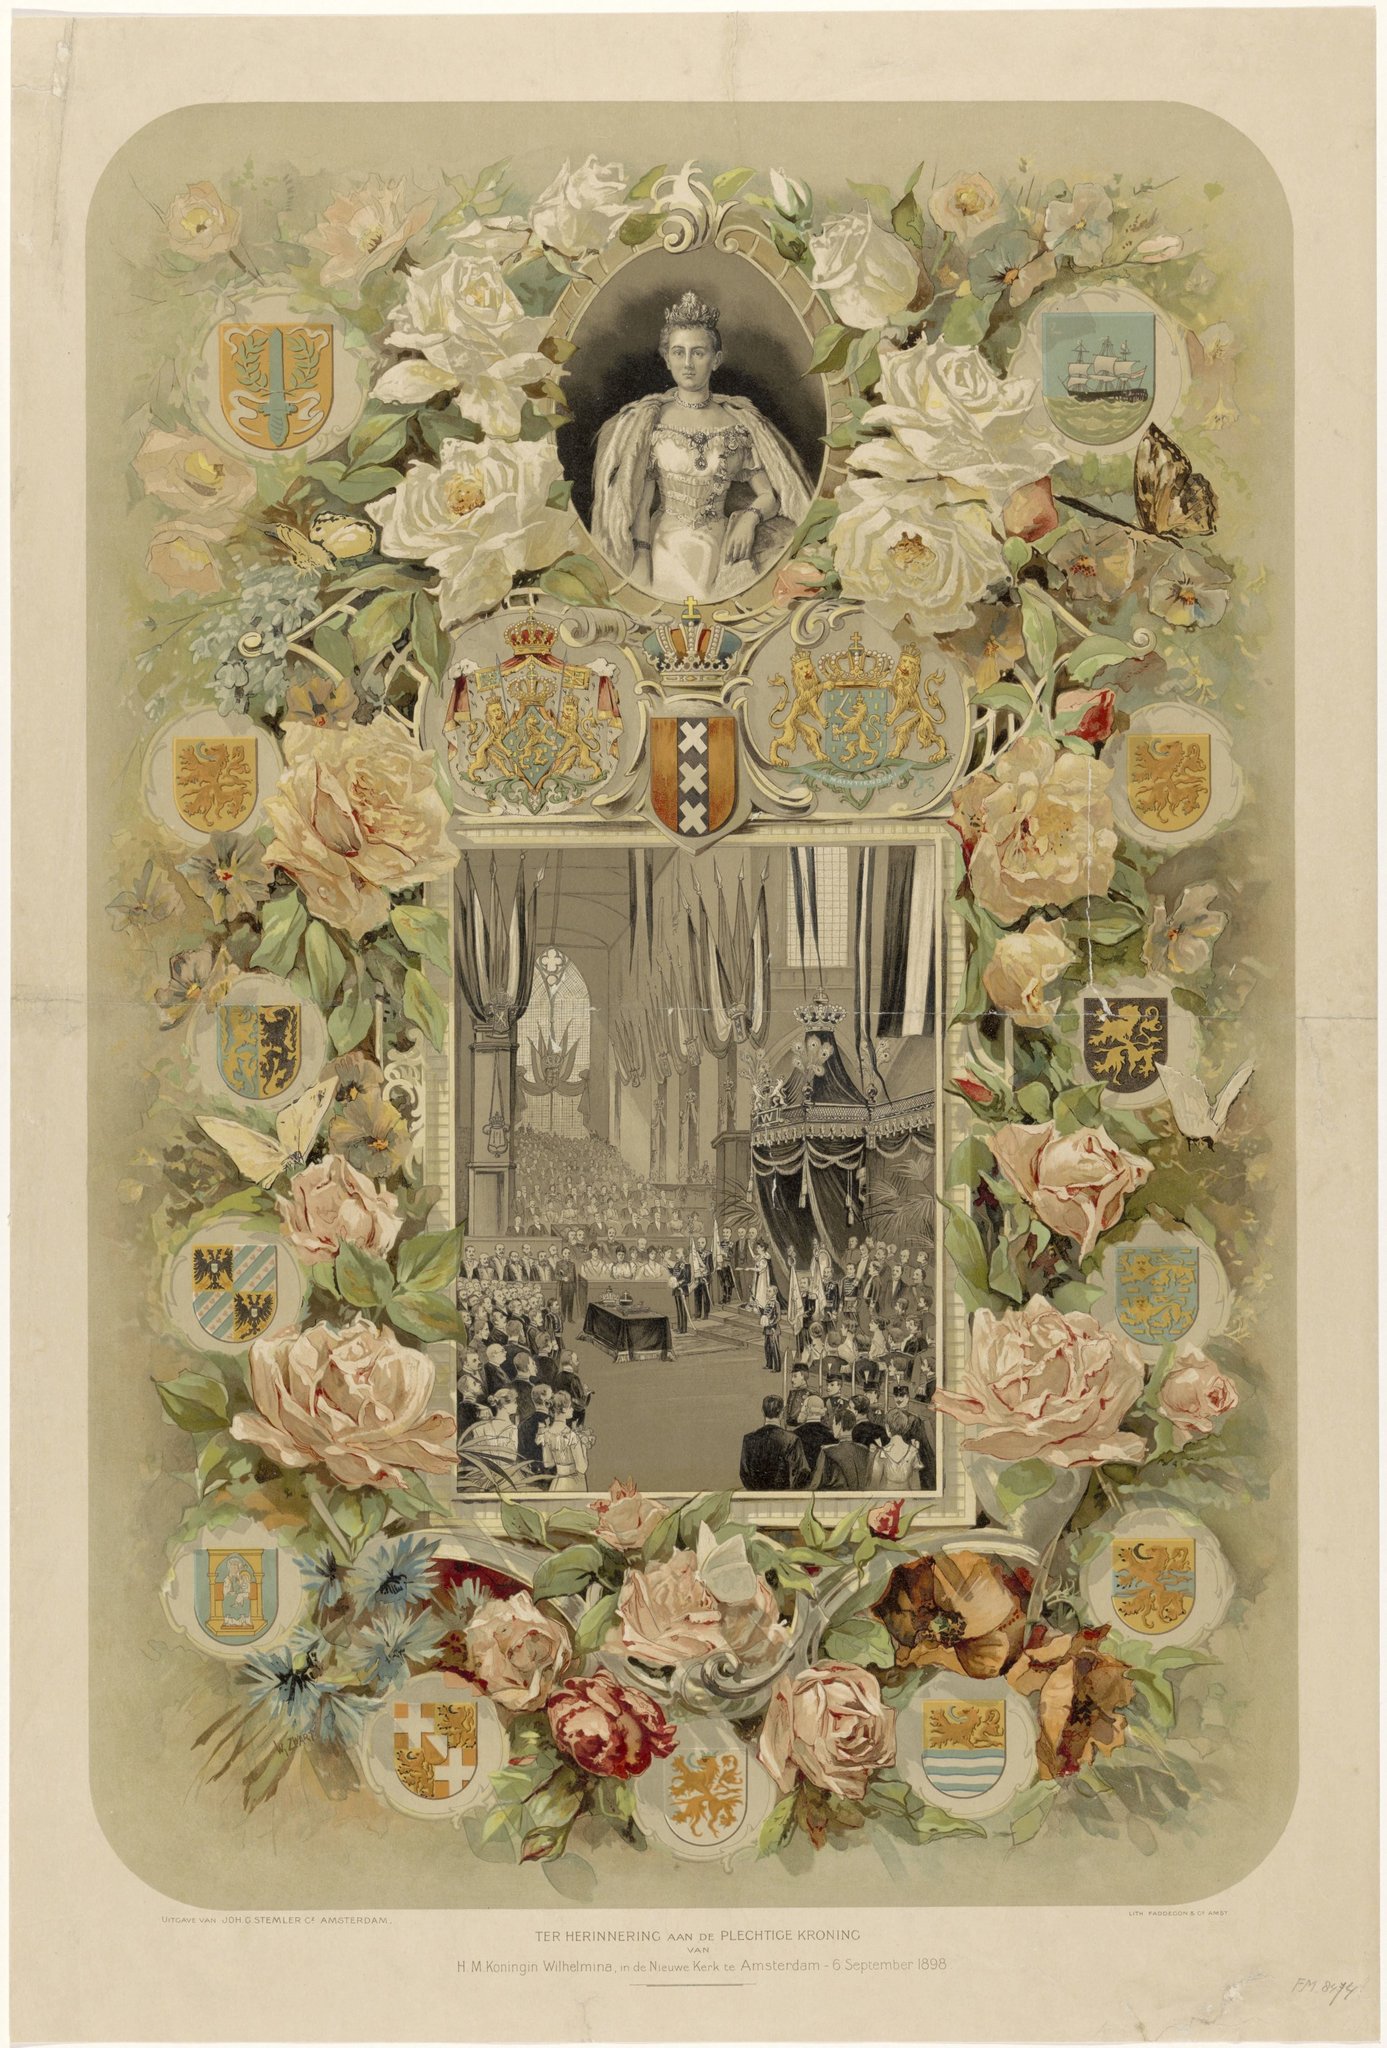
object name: print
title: Ter herinnering aan de Plechtige Kroning van H.M. Koningin Wilhelmina, in de Nieuwe Kerk te Amsterdam - 6 September 1898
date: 1898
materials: paper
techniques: chromolithography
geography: amsterdam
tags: the hague, wilhelmina of the netherlands, installation of a ruler - bb - female ruler, flowers: rose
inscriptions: collector's mark: Lugt 2228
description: Gedenkblad ter herinnering aan de inhuldiging van Koningin Wilhelmina in de Nieuwe Kerk te Amsterdam op 6 september 1898. Centraal een voorstelling van de koningin die de eed aflegt. Hieromheen verschillende wapens, o.a. de provinciewapens, tussen rozen. Bovenaan een portret van Wilhelmina.